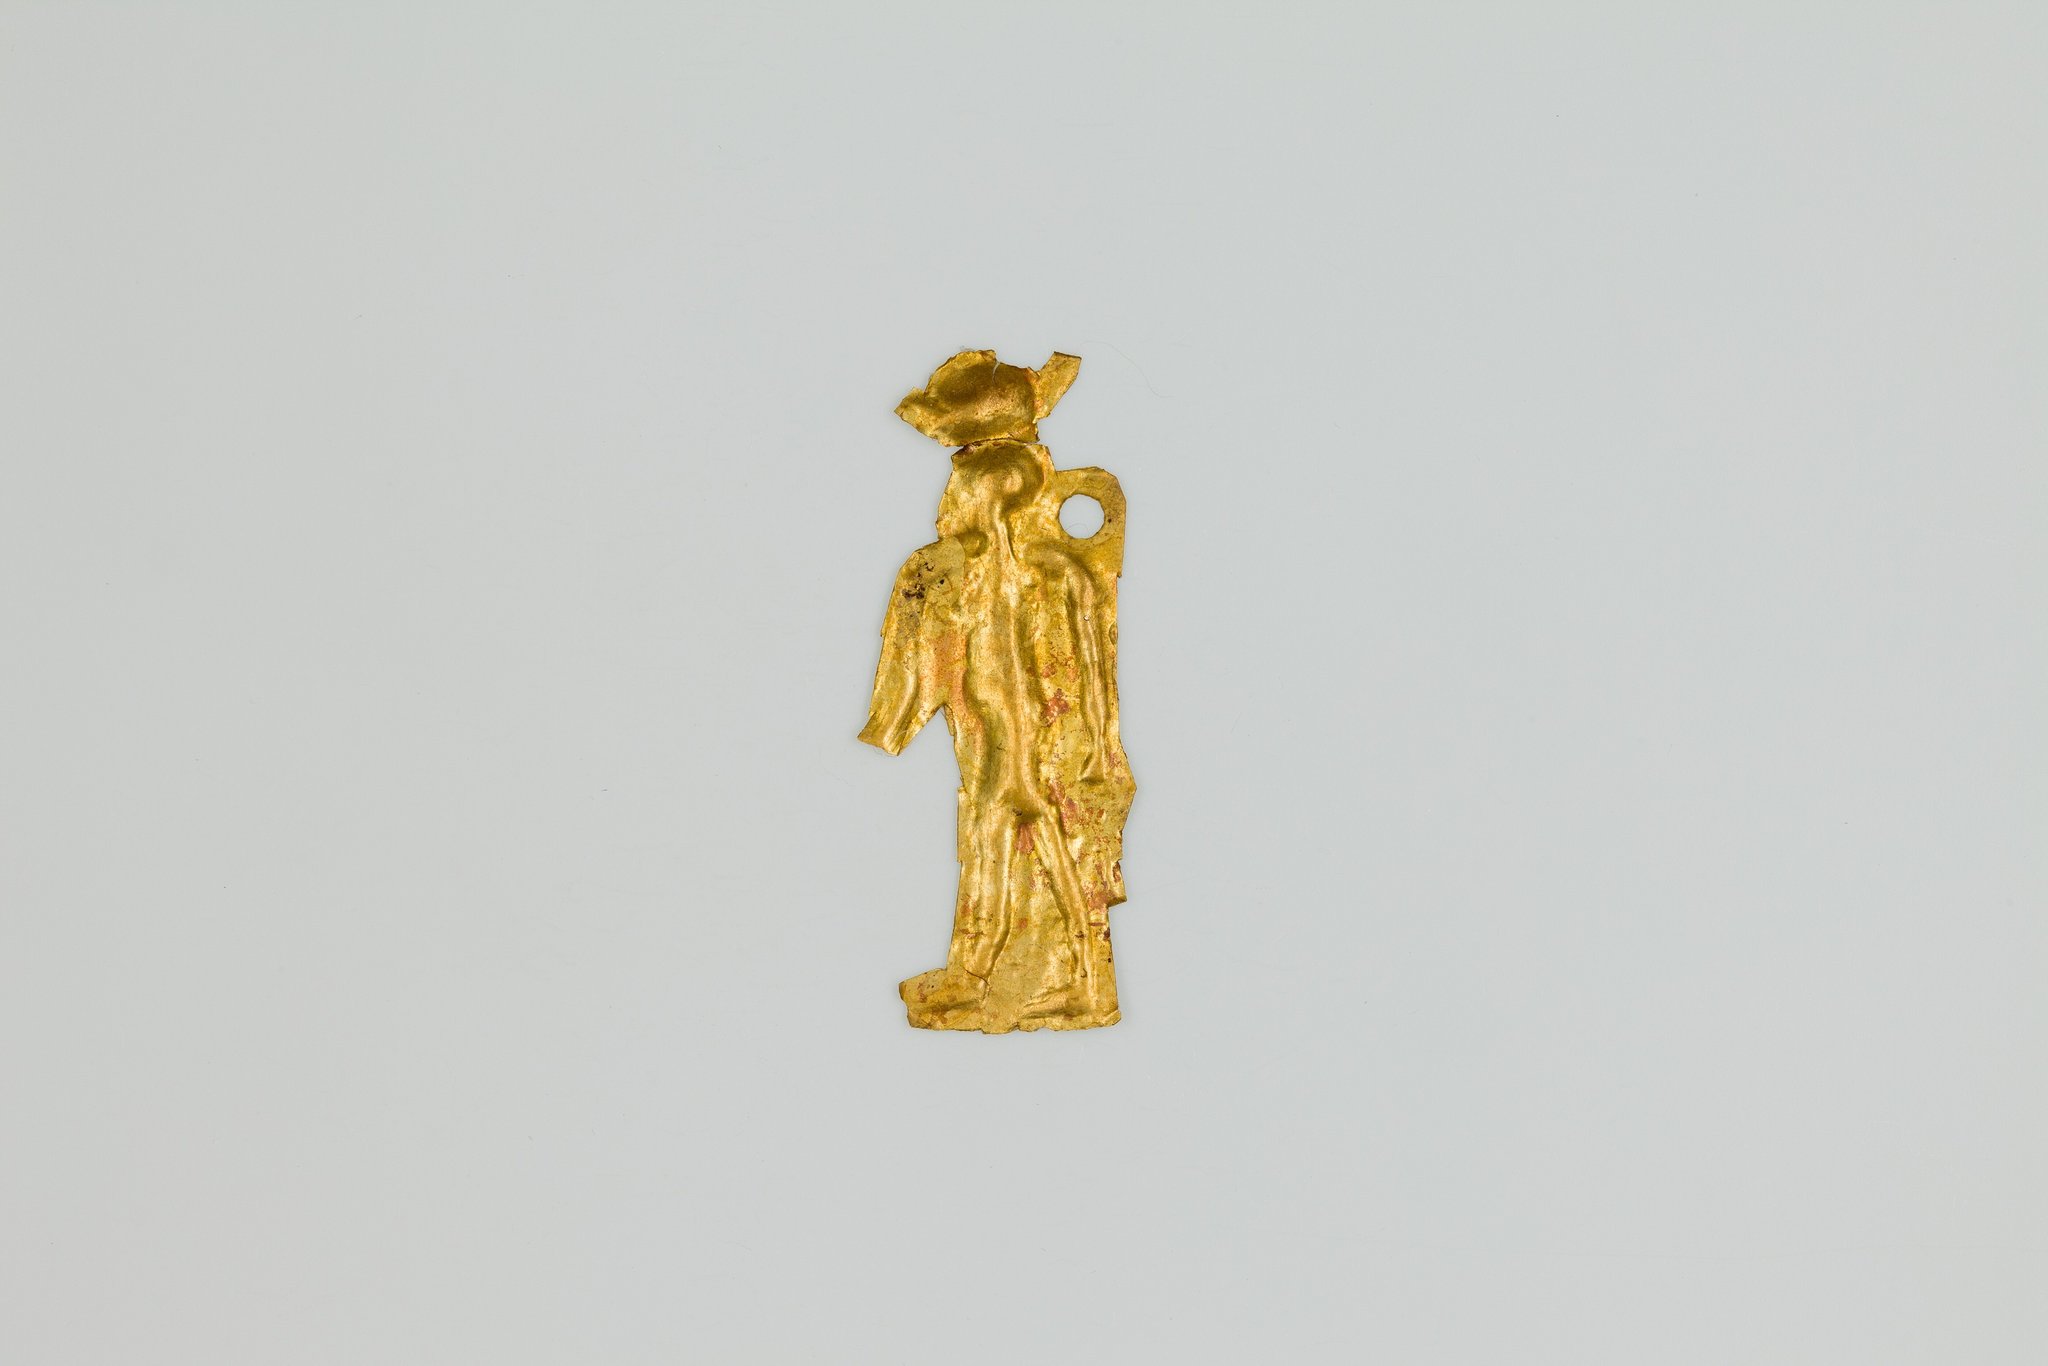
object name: amulet, khonsu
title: Khonsu amulet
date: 664-380 BCE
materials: gold